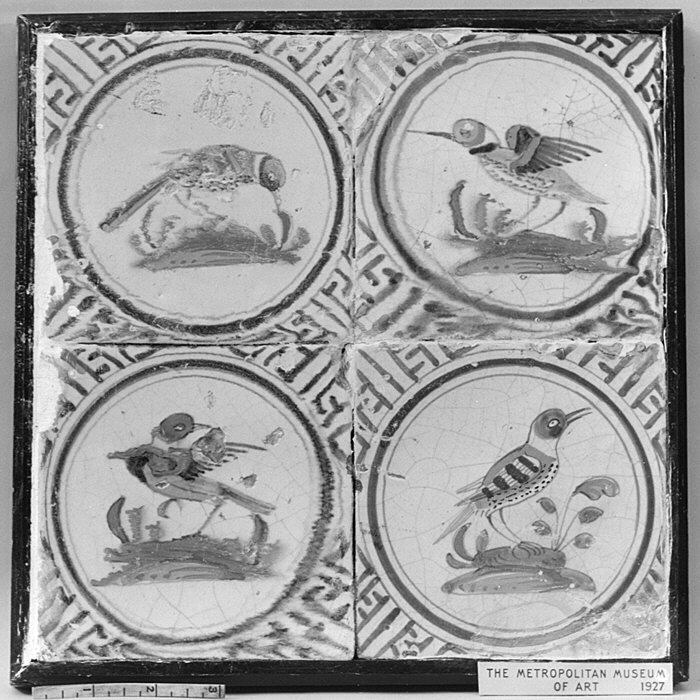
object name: tile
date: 1640-1660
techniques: glazing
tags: birds